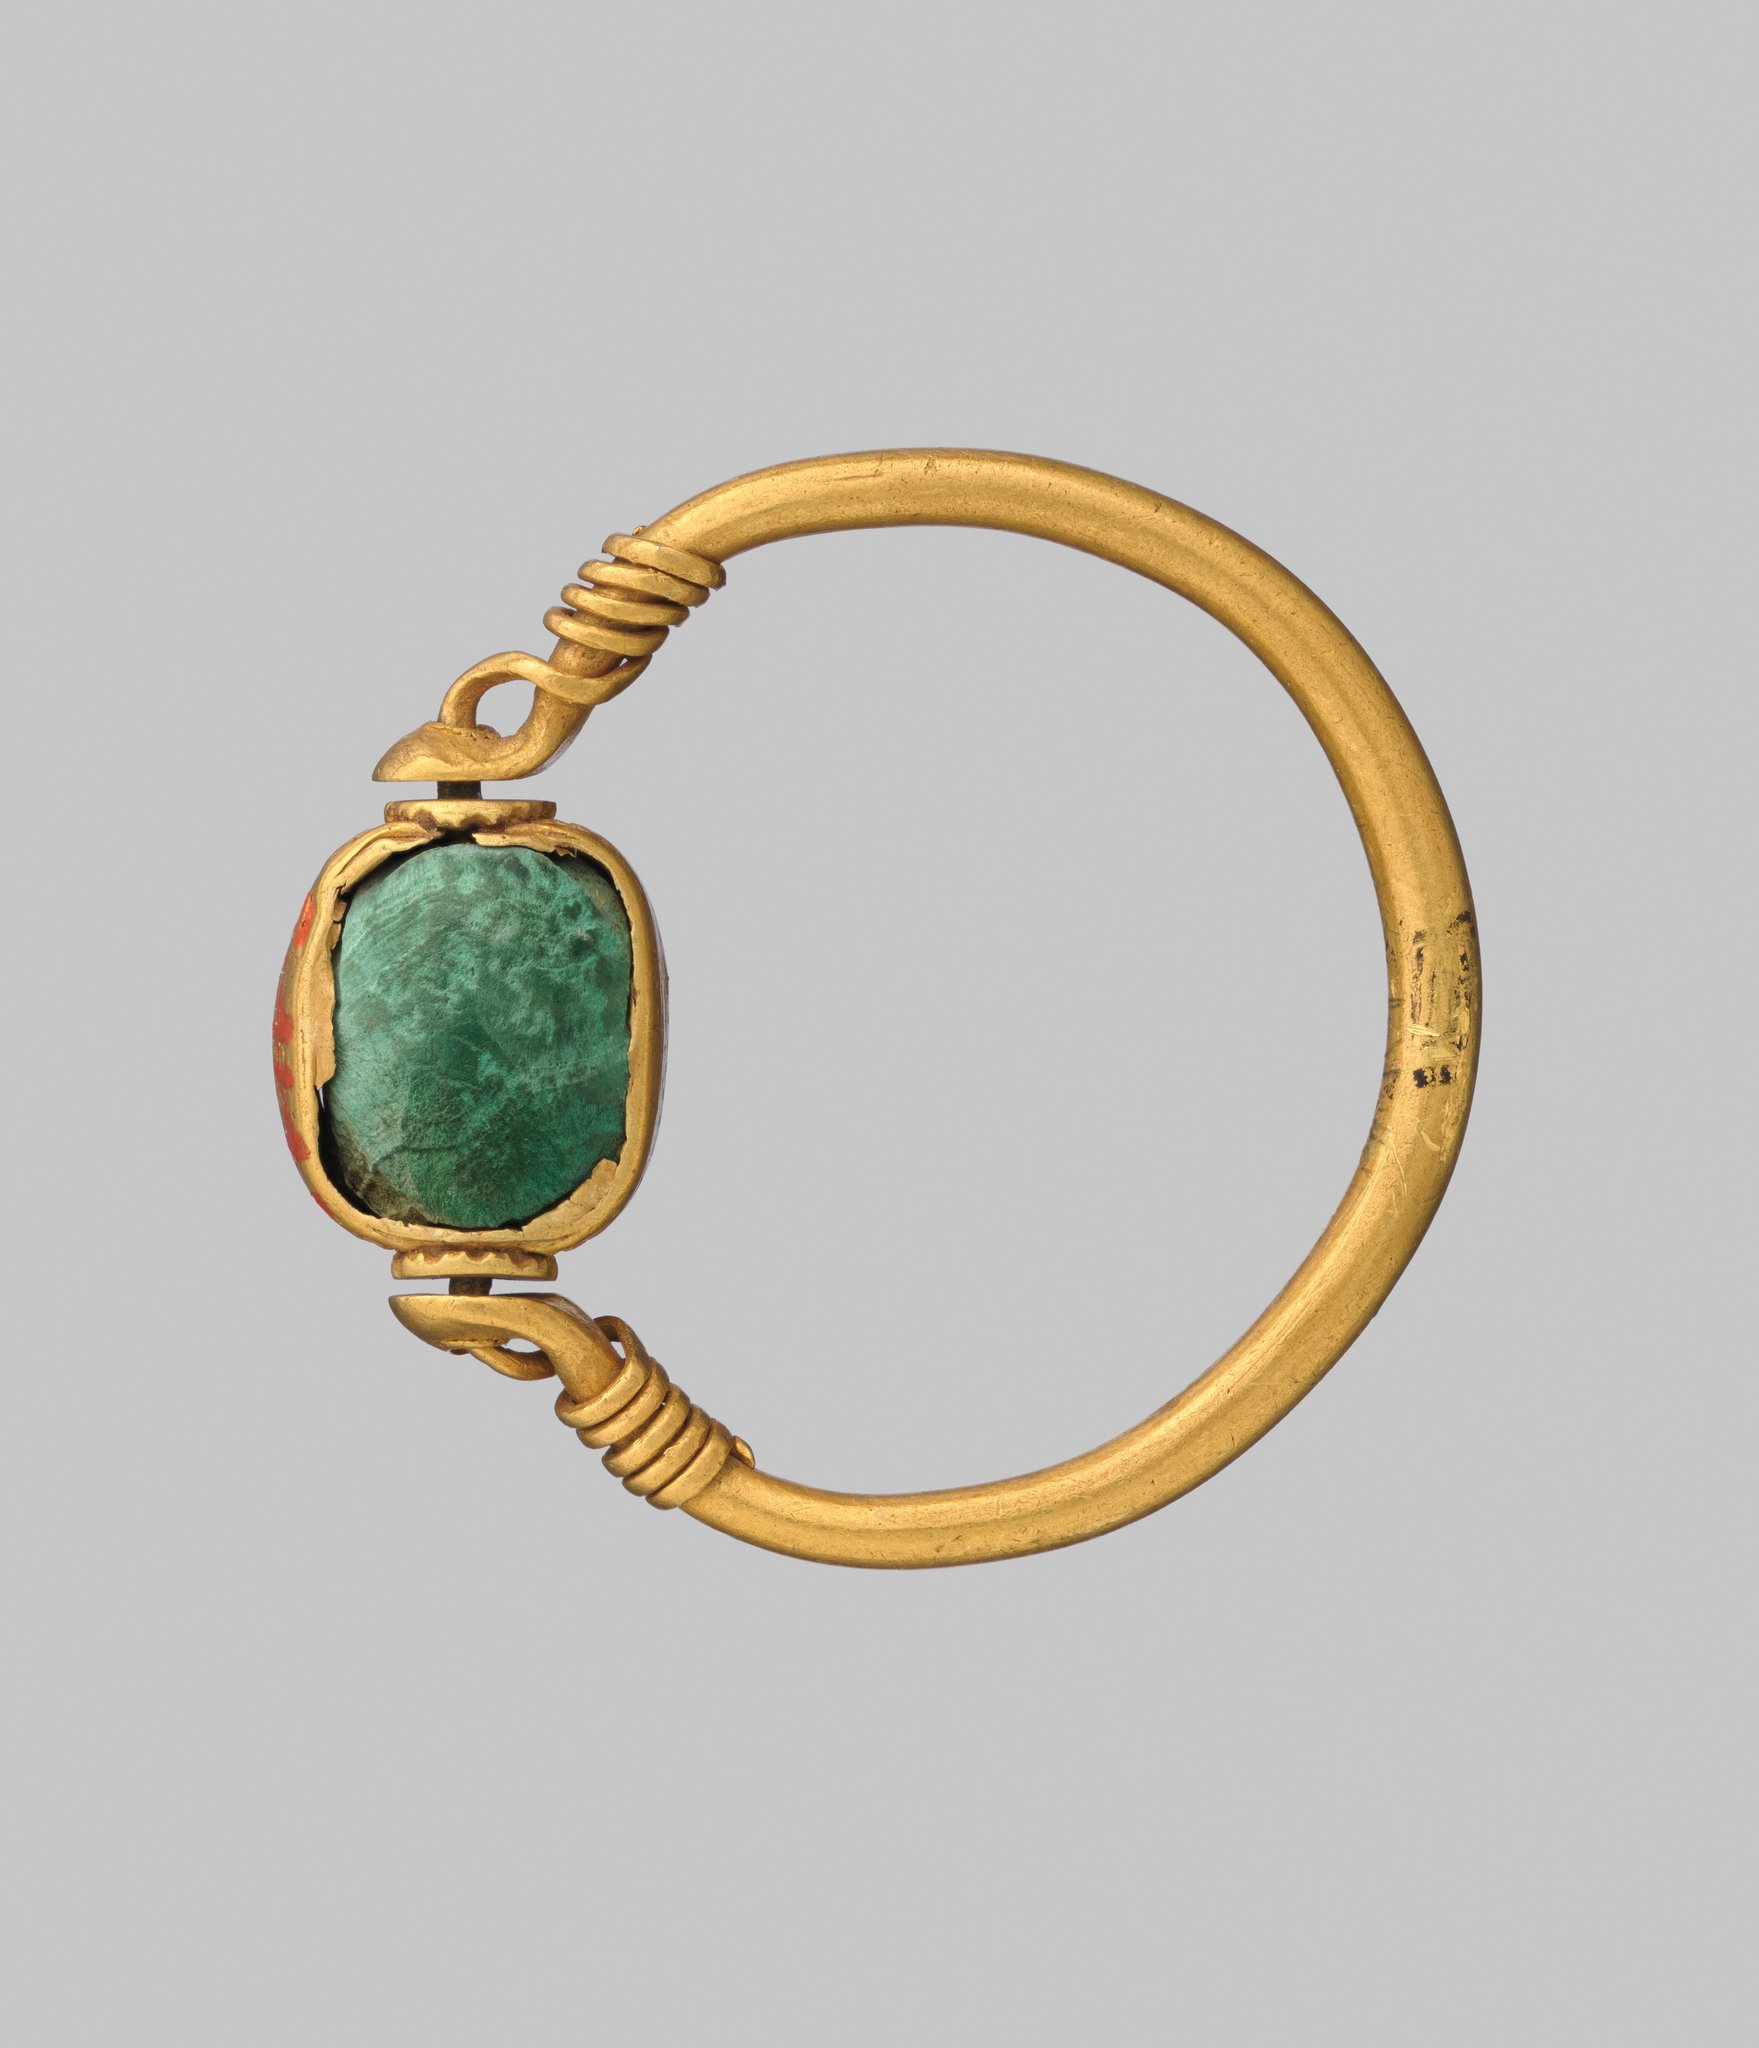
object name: ring with cable border, malachite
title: Gold ring with scaraboid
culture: cypriot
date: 700-501 BCE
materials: glass, gold, paste